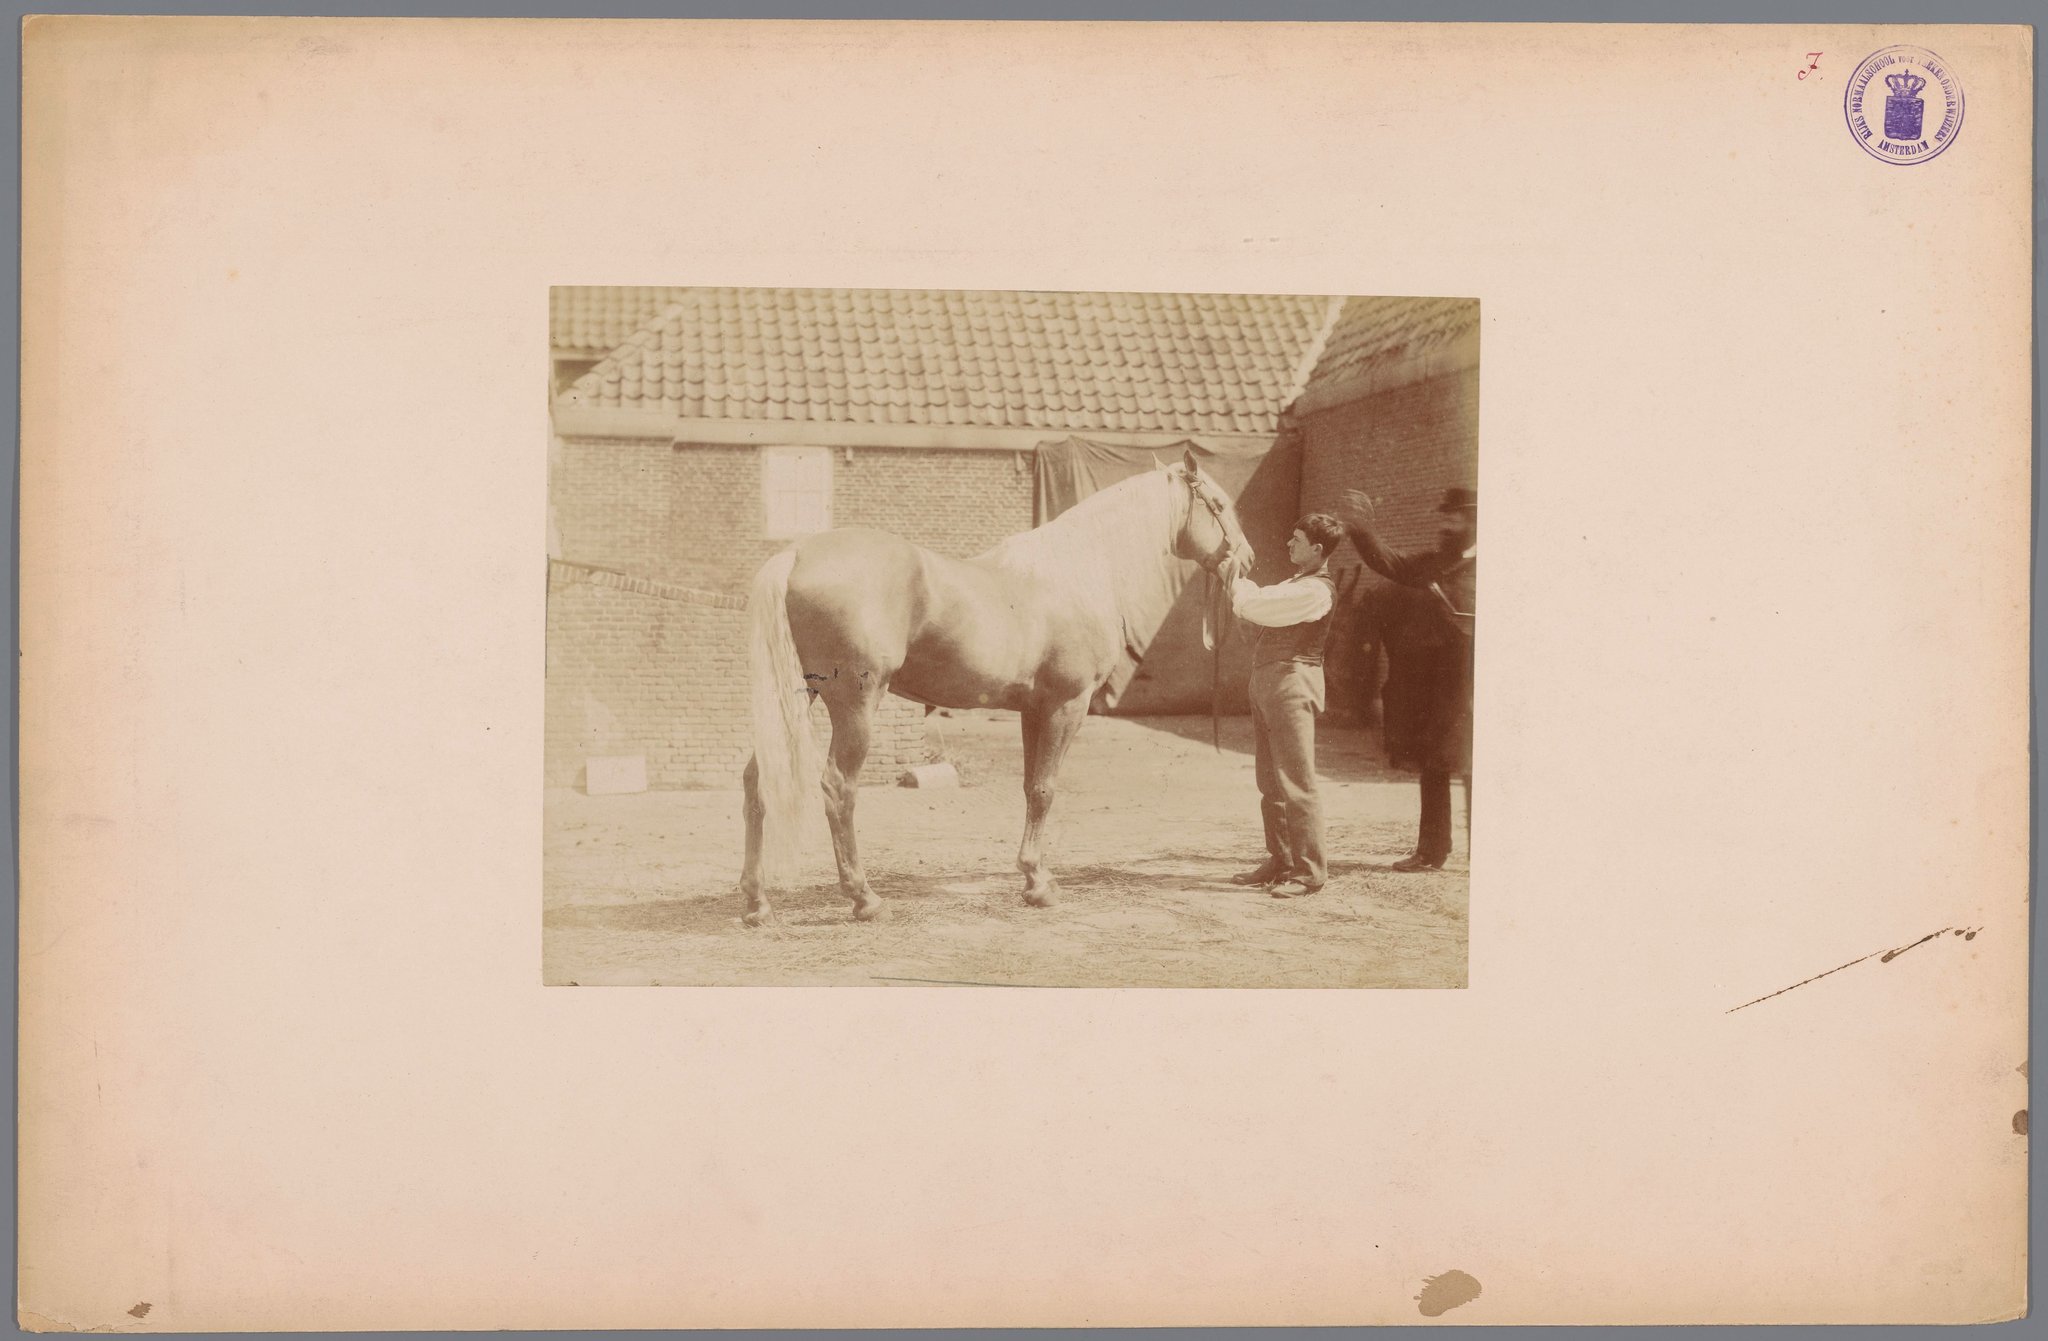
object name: photograph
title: Twee mannen met een paard op een binnenplaats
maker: willem frederik vinkenbos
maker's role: fotograaf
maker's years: 1831-1896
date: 1875-1900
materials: cardboard, photographic support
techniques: albumen print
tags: man and animal, horse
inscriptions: name: ‘PHOTOGRAPHIE W.F. VINKENBOS DE RIEMERSTRAAT 111 DEN HAAG’, inscription: ‘F.’, number: ‘No 7. Rothbart’, collector's mark: ‘RIJKS NORMAALSCHOOL VOOR TEEKENONDERWIJZERS AMSTERDAM’